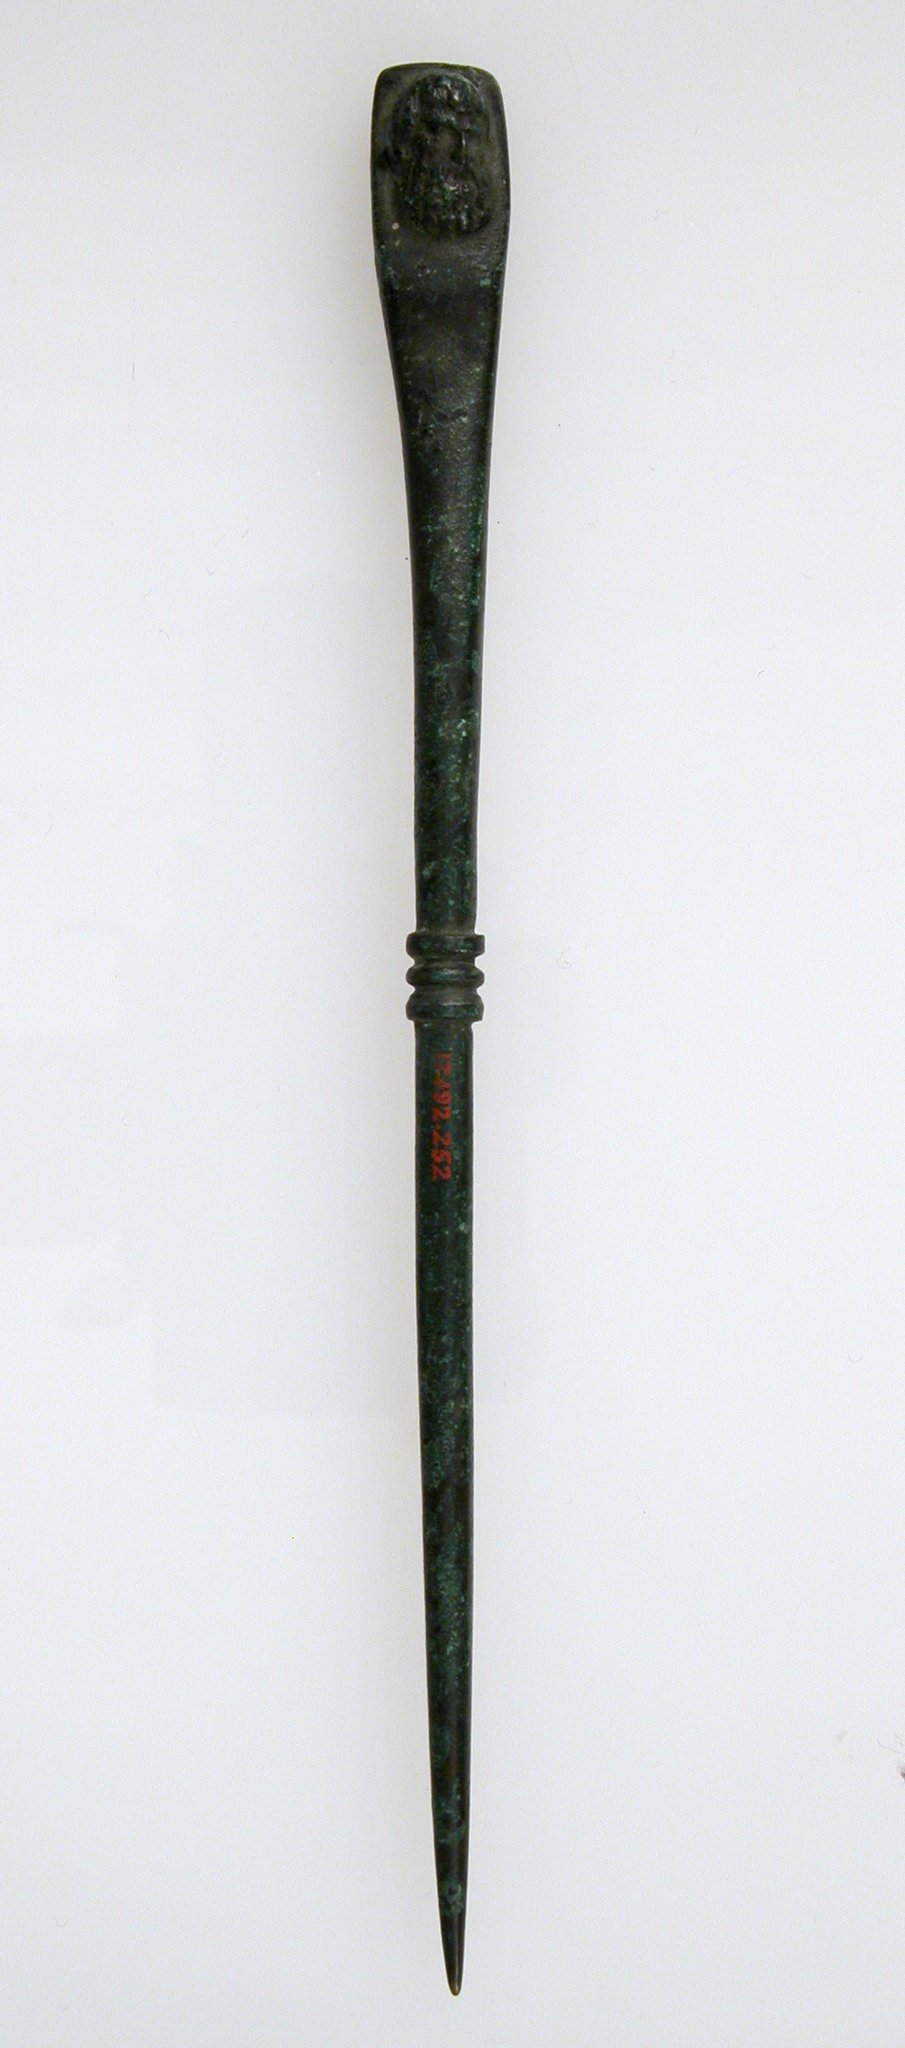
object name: stylus or hairpin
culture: roman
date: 101-300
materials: copper alloy